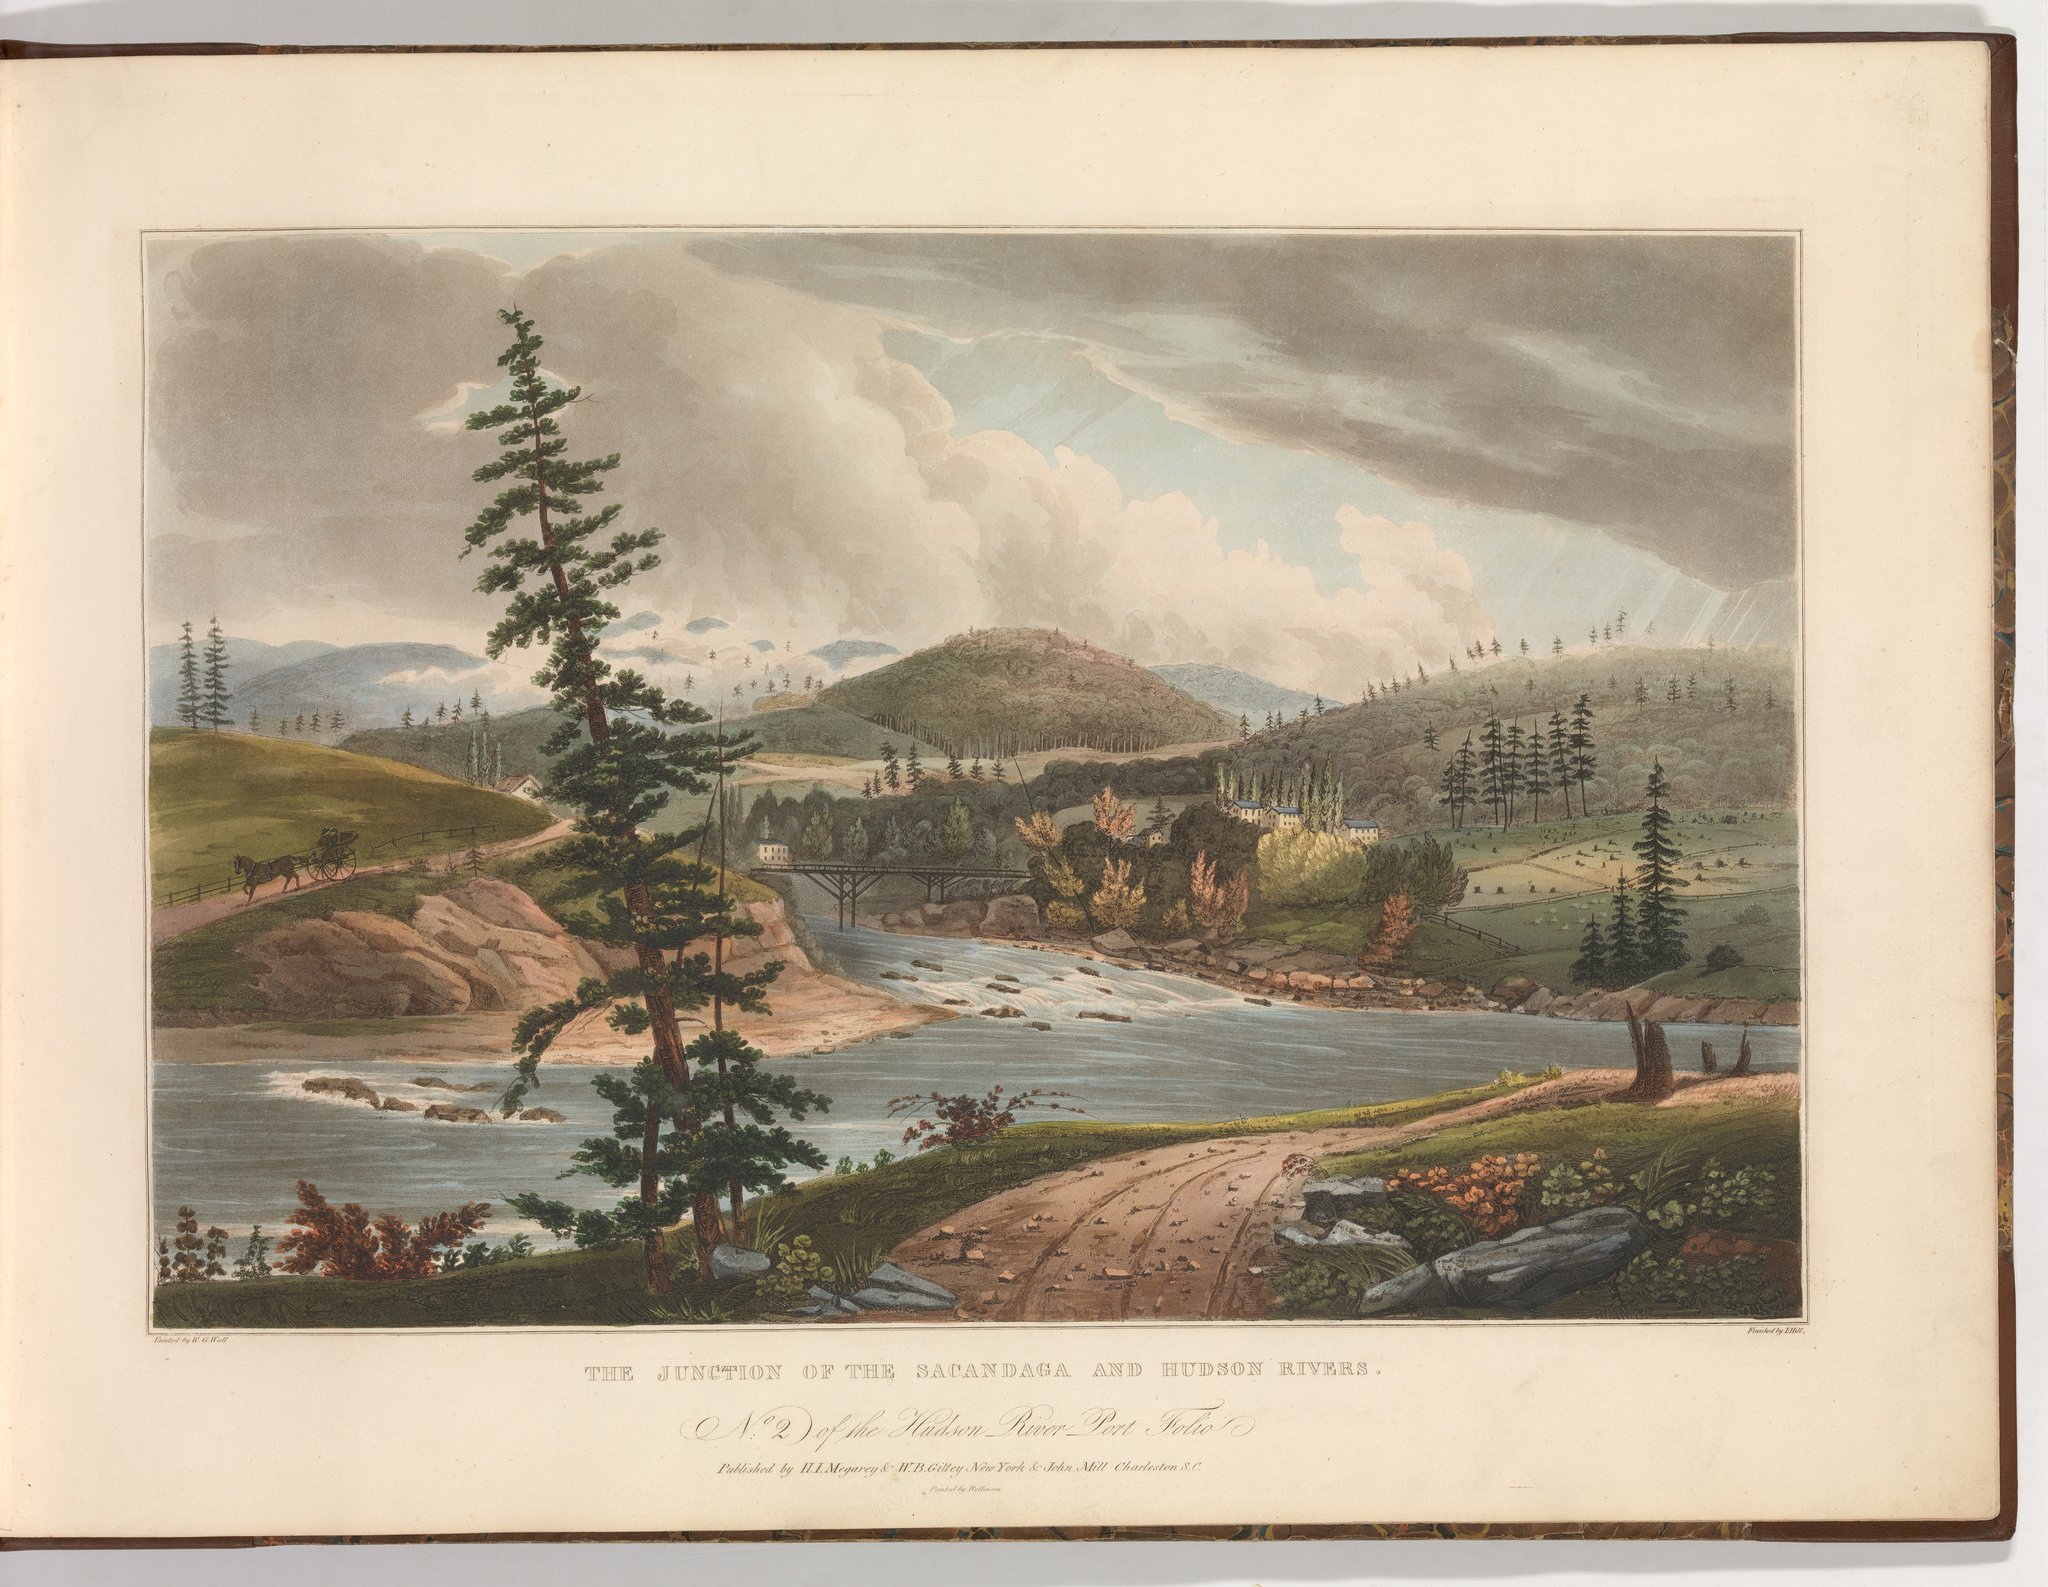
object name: print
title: Junction of the Sacandaga and Hudson Rivers (No. 2 of The Hudson River Portfolio)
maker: john hill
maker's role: etcher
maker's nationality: american, born england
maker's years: 1770-1850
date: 1821-1822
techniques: aquatint, hand coloring, printing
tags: rivers,hills,landscapes,trees